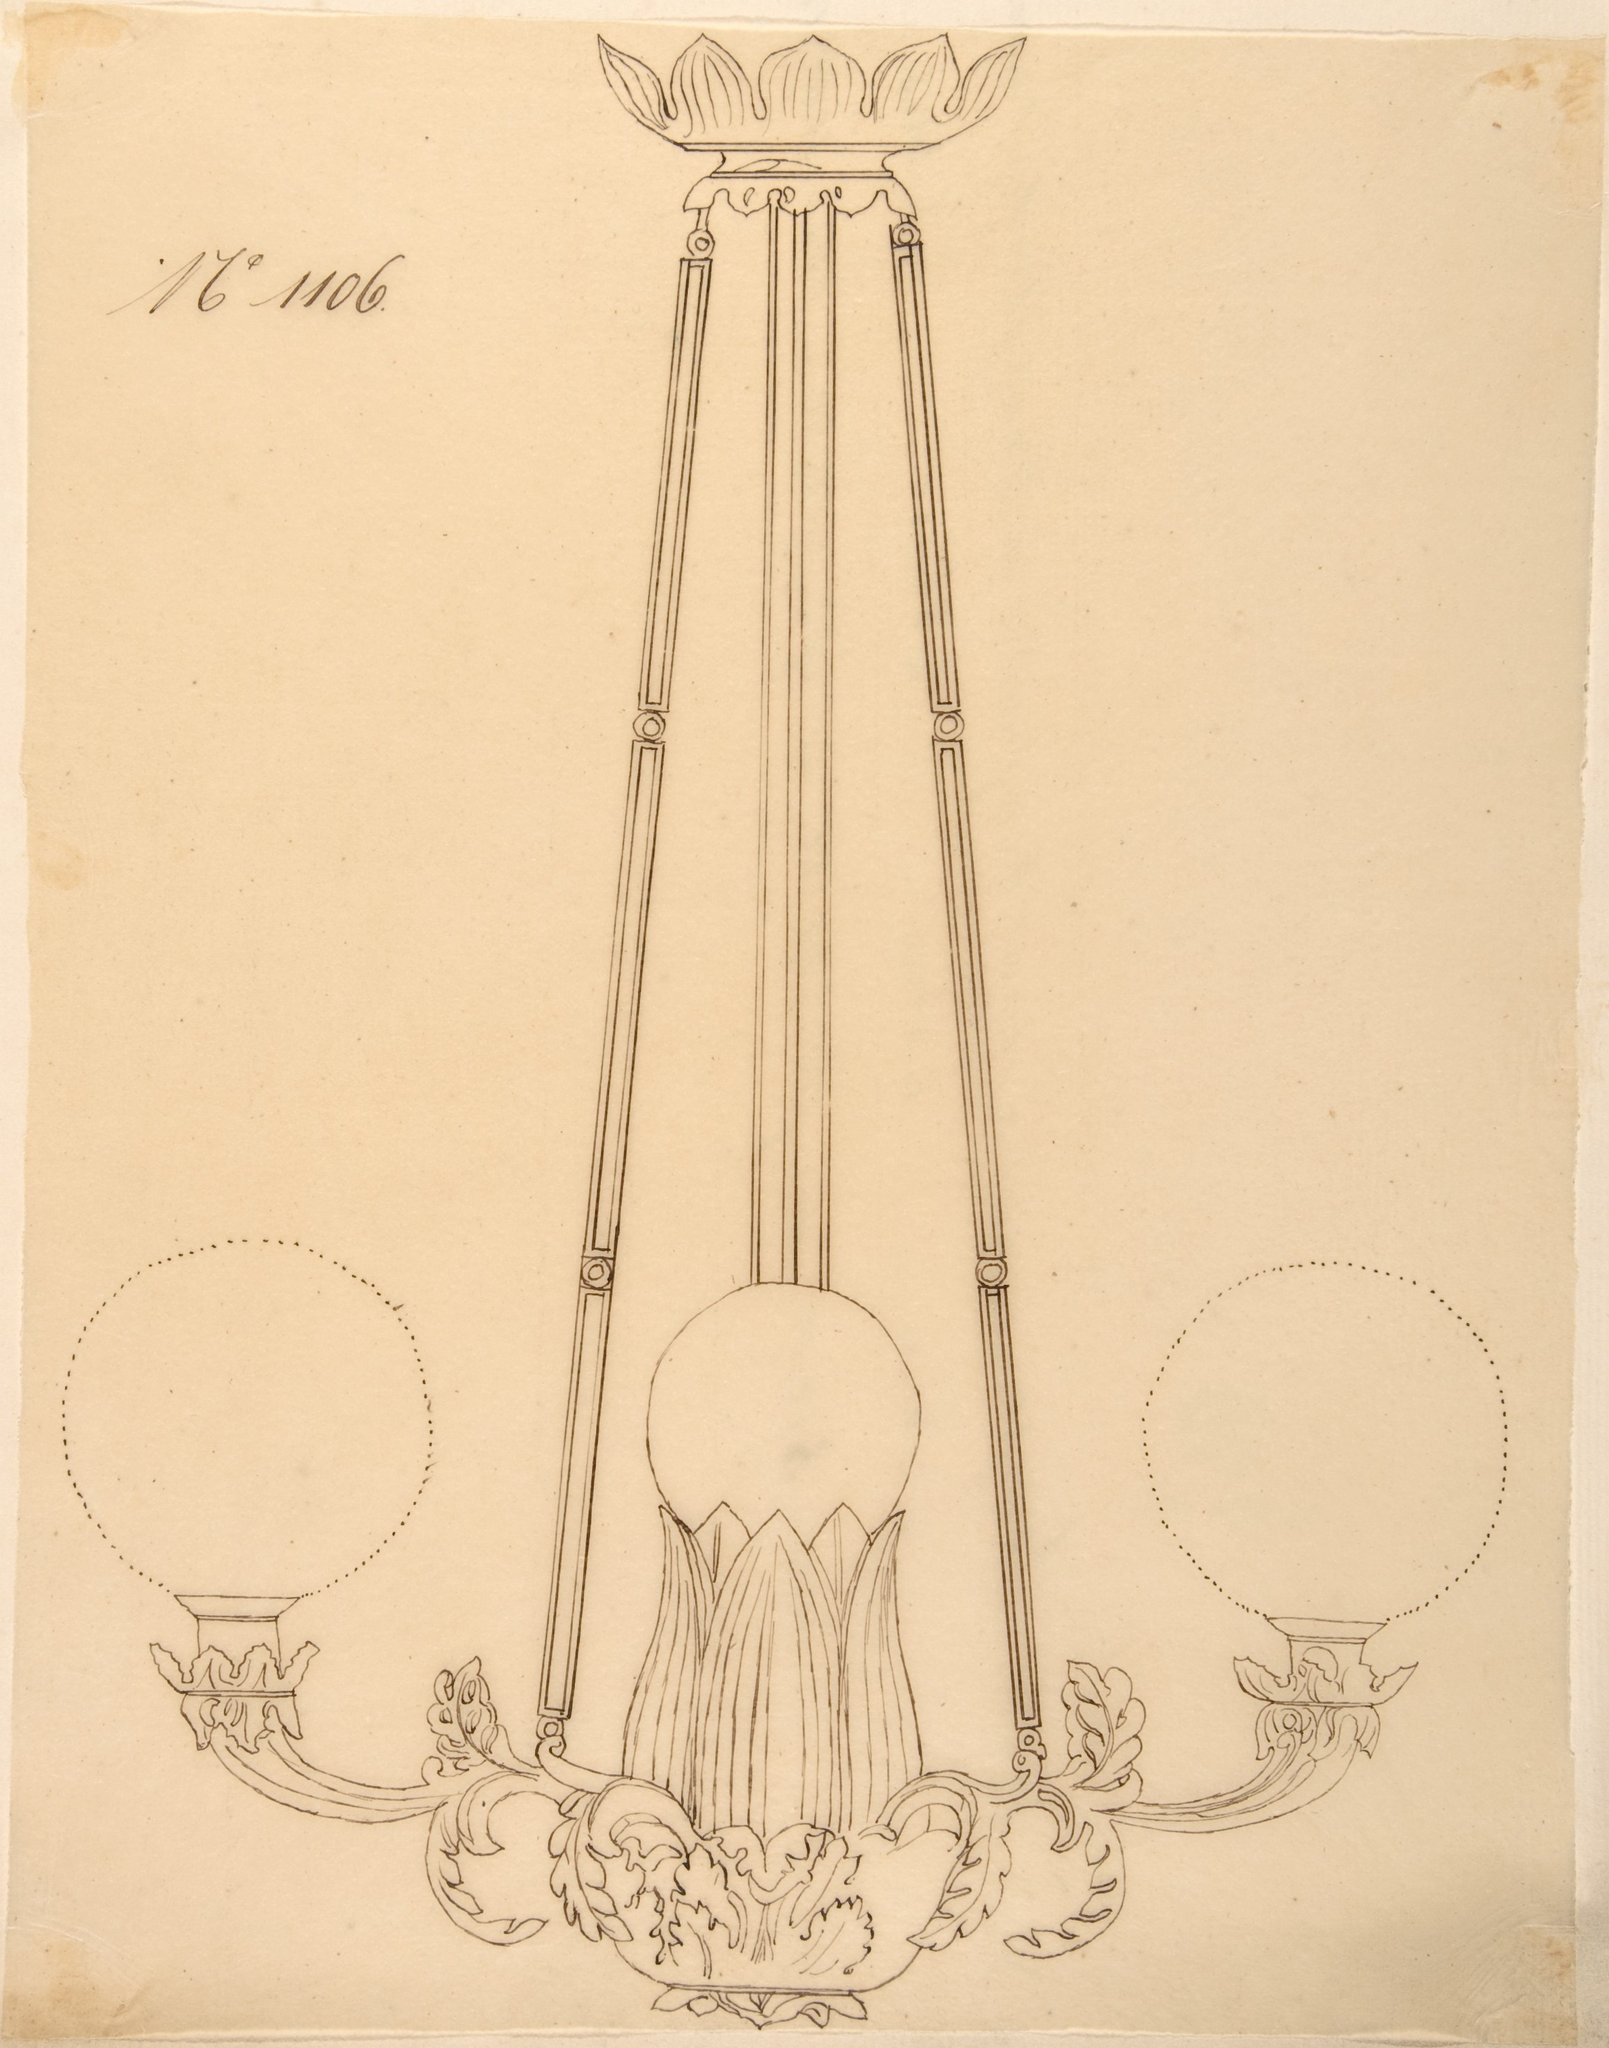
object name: drawing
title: Design for a Chandelier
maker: anonymous, french, 19th century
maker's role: artist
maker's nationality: french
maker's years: 1800-1900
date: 1801-1900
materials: ink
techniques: pen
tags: chandelier